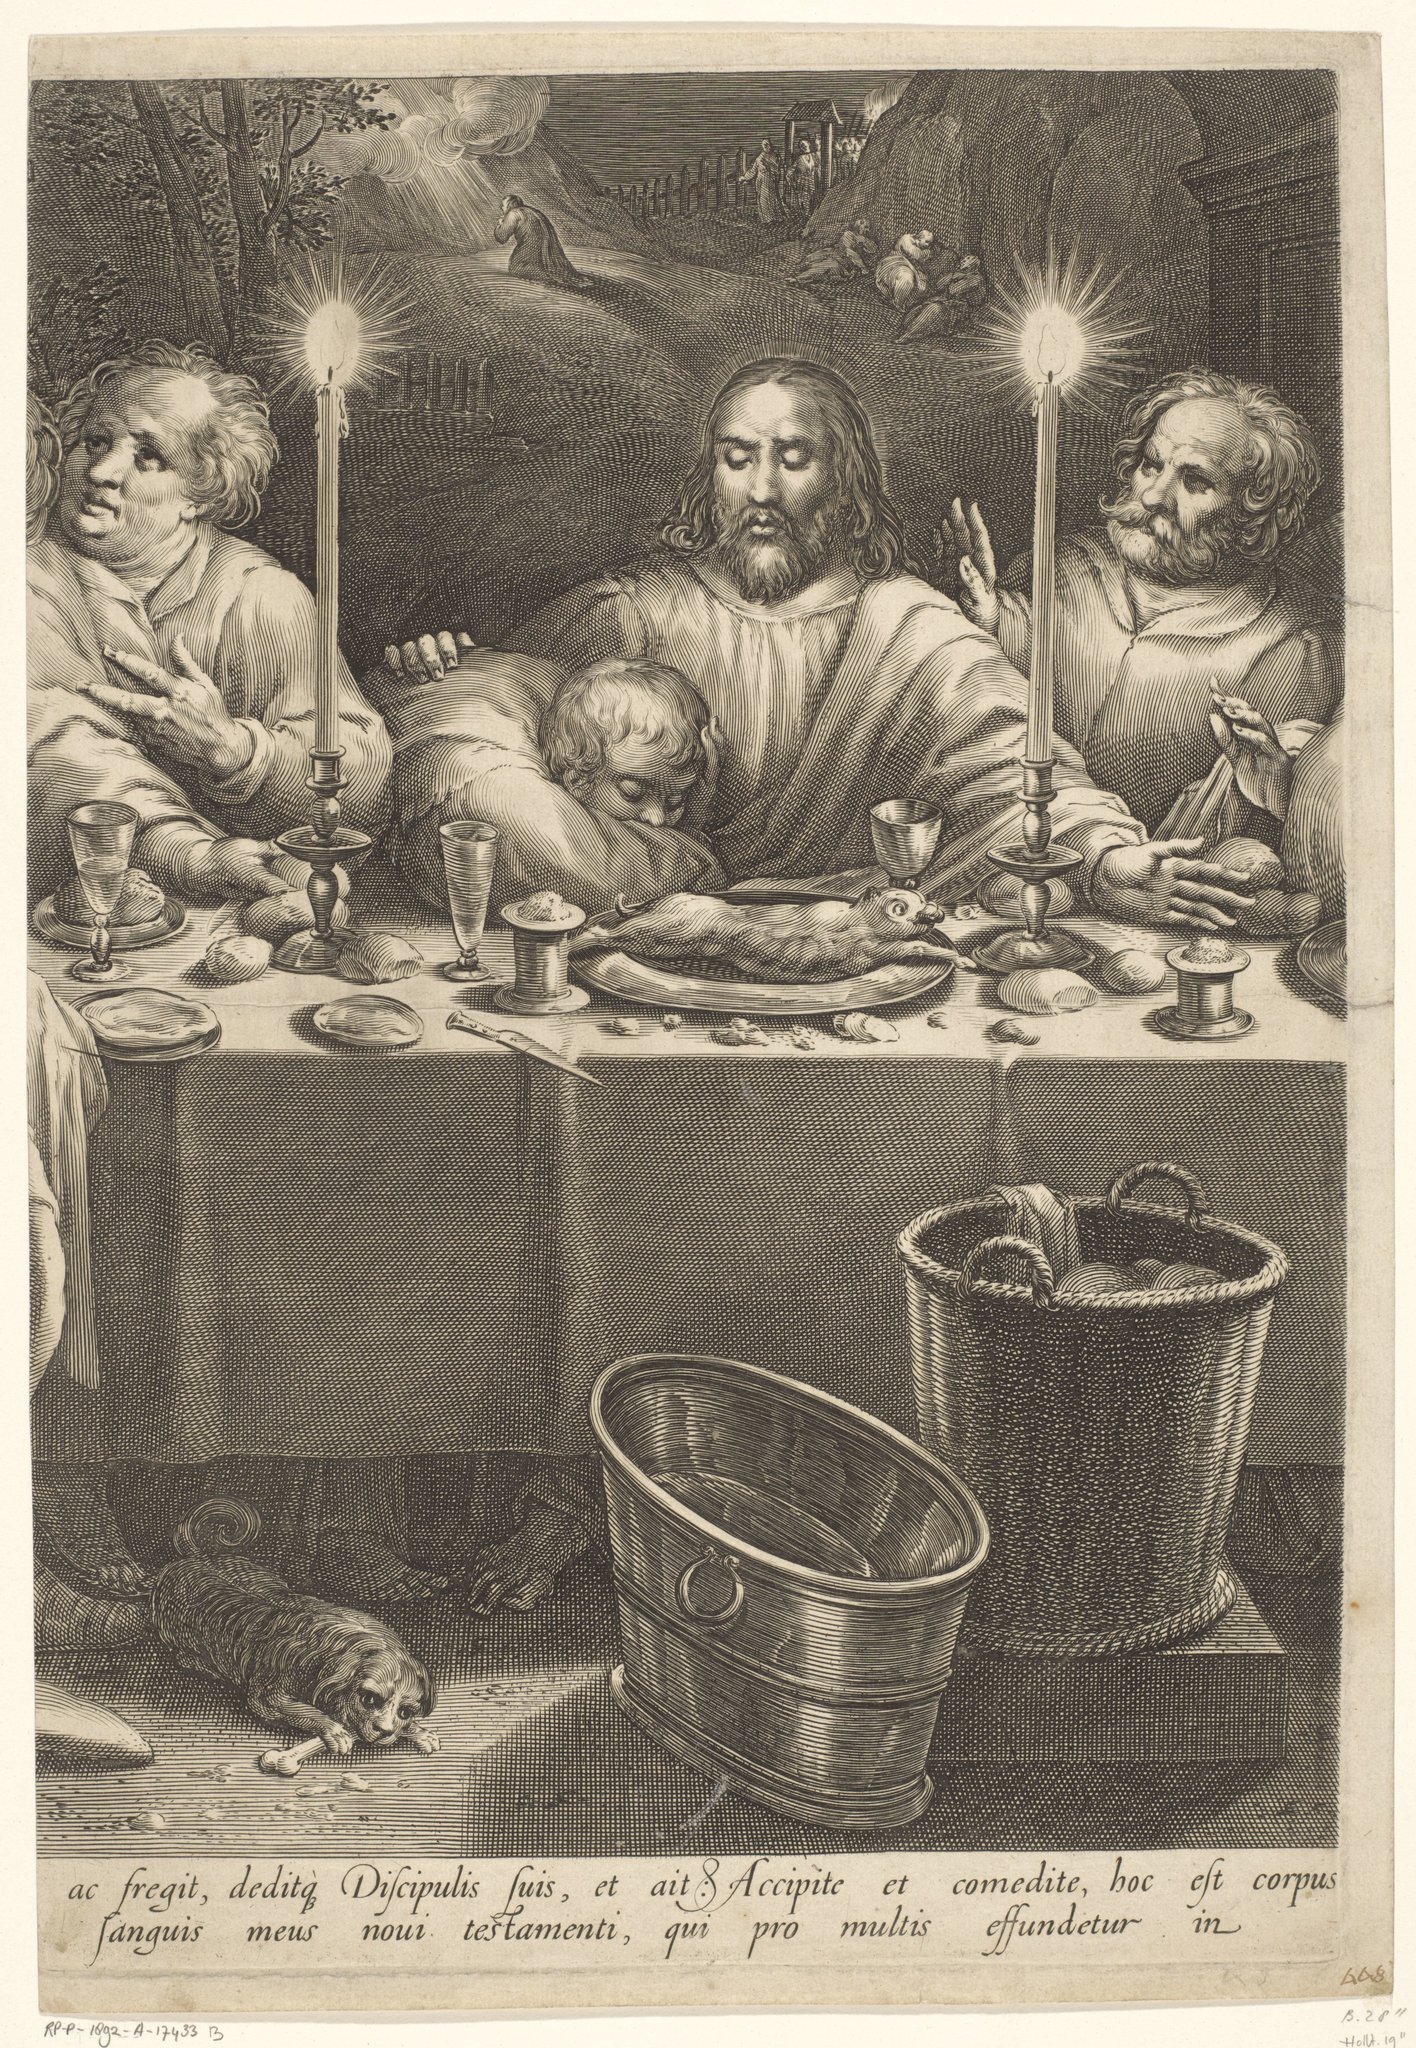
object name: print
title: Laatste avondmaal (midden blad)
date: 1594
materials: paper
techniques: engraving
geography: amsterdam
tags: announcement of the betrayal of christ, and the reaction of the apostles, christ's prayer in the garden of gethsemane during the night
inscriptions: collector's mark: Lugt 2228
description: Christus zit tijdens het laatste avondmaal ten midden van zijn discipelen. Johannes ligt tegen zijn borst. De discipelen naast hem reageren verbaasd op zijn uitspraak dat een van hen hem zal verraden. Op tafel kaarsen en eten. Onder tafel een hond met een bot. Op de achtergrond de voorstelling van Christus in de hof van Getsemane.